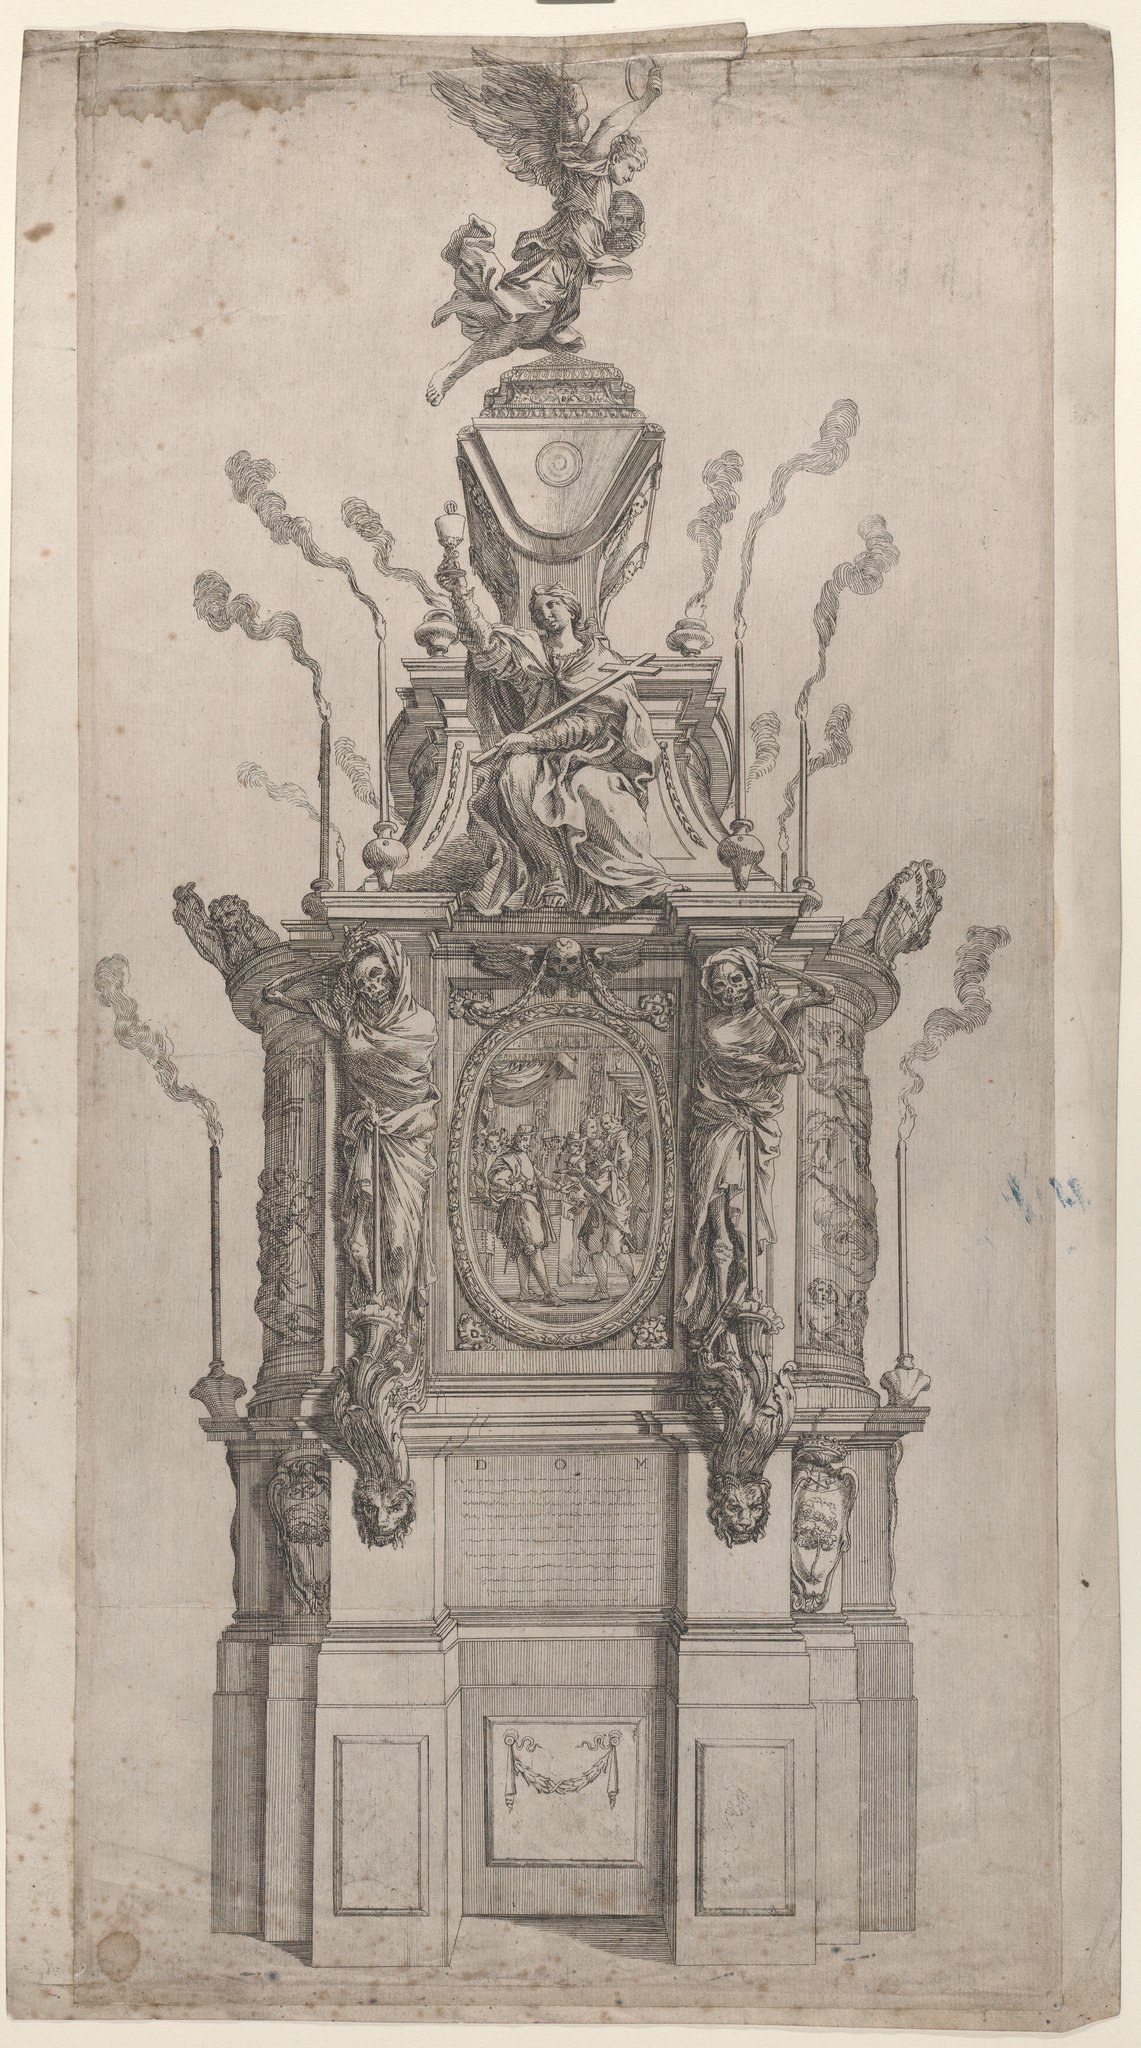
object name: print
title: Catafalque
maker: giovanni francesco grimaldi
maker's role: artist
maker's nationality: italian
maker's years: 1606-1680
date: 1626-1680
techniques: etching